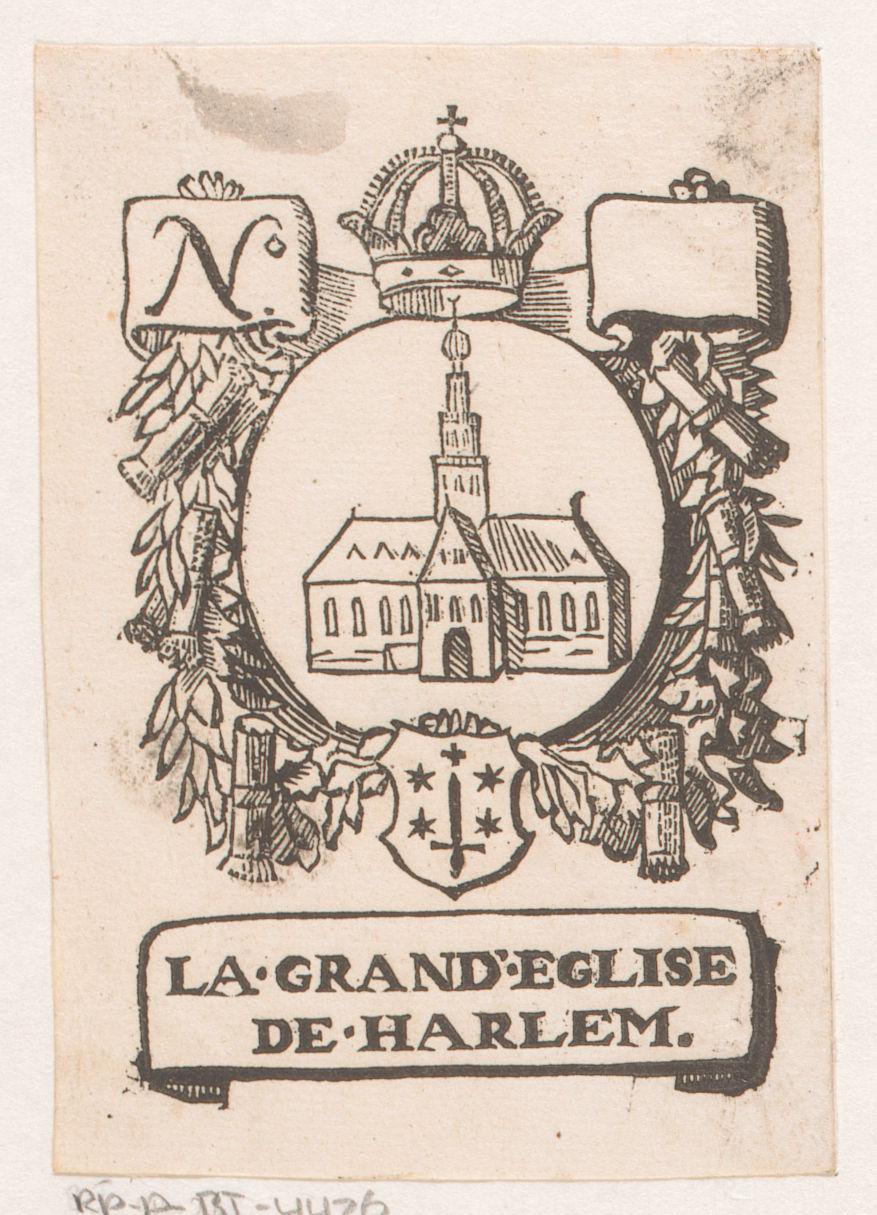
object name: print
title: Vignet met de Sint-Bavokerk te Haarlem en het wapen van de stad Haarlem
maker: Anonymous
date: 1600-1699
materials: paper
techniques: woodcut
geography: netherlands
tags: coat of arms (as symbol of the state, etc.) (+ city; municipal), vignette, haarlem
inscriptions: collector's mark: Lugt 240